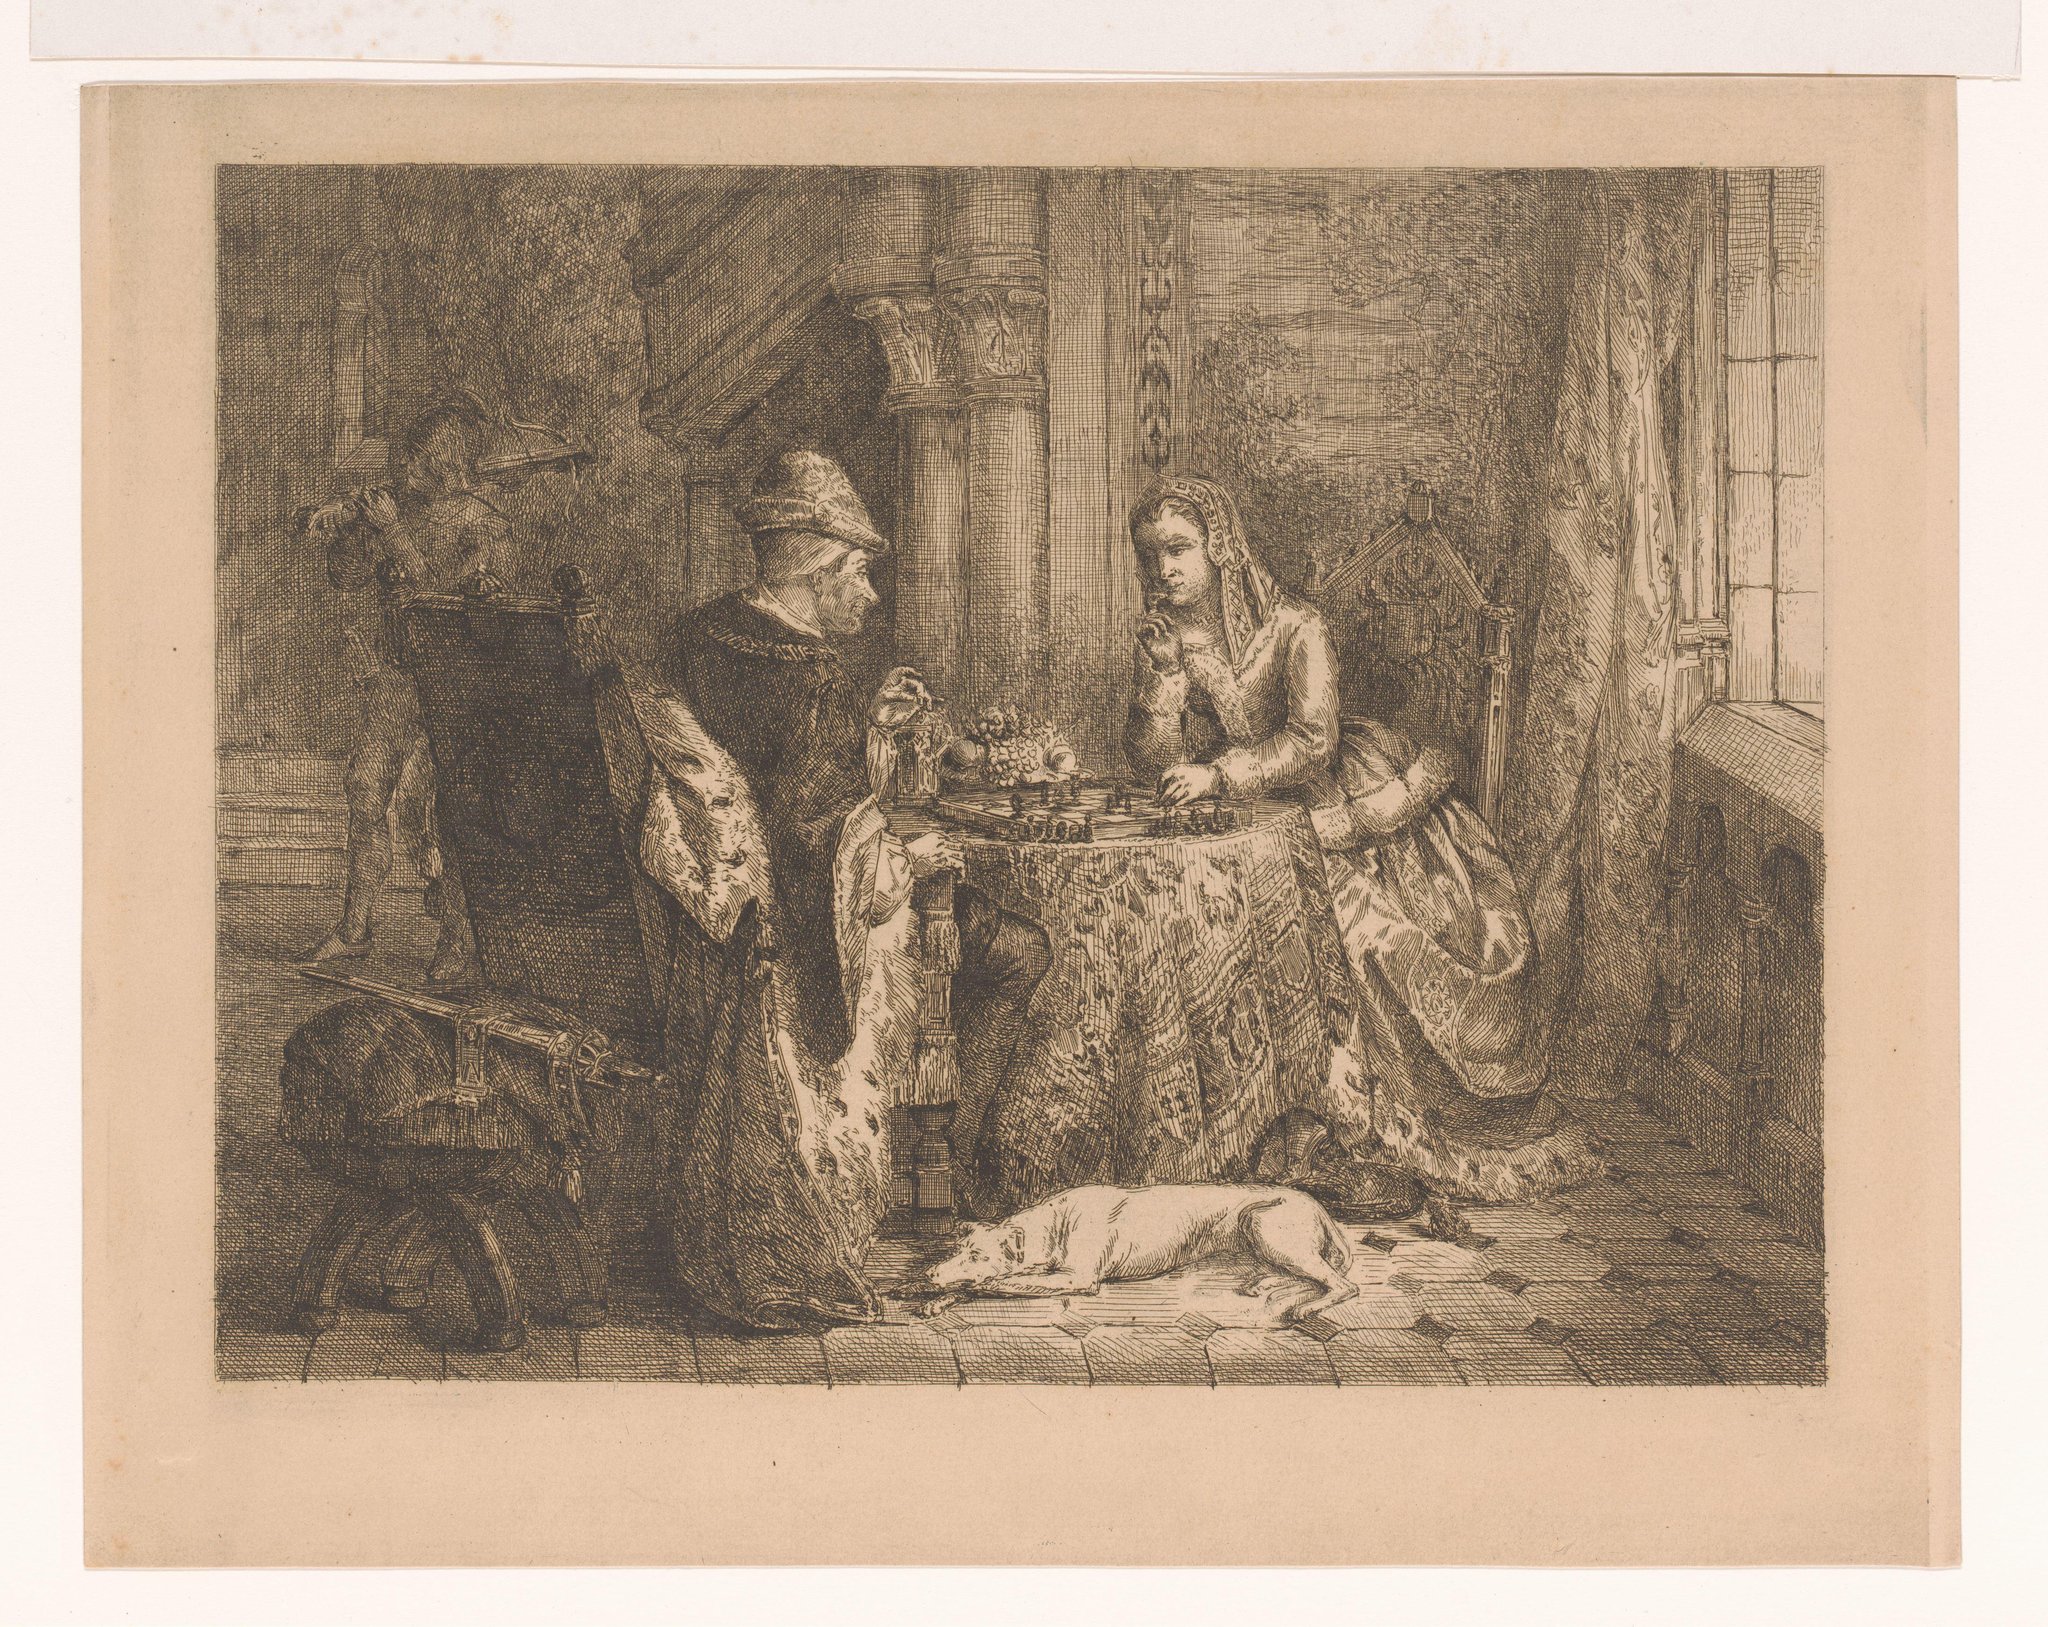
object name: print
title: Lodewijk XI en zijn dochter Anna van Beaujeu spelen schaak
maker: adrien joseph verhoeven-ball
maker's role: draughtsman, print maker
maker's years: 1824-1882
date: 1866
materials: paper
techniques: drypoint, etching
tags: genappe, chess, historical persons, king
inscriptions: collector's mark: Lugt 1485, collector's mark: Lugt 2228